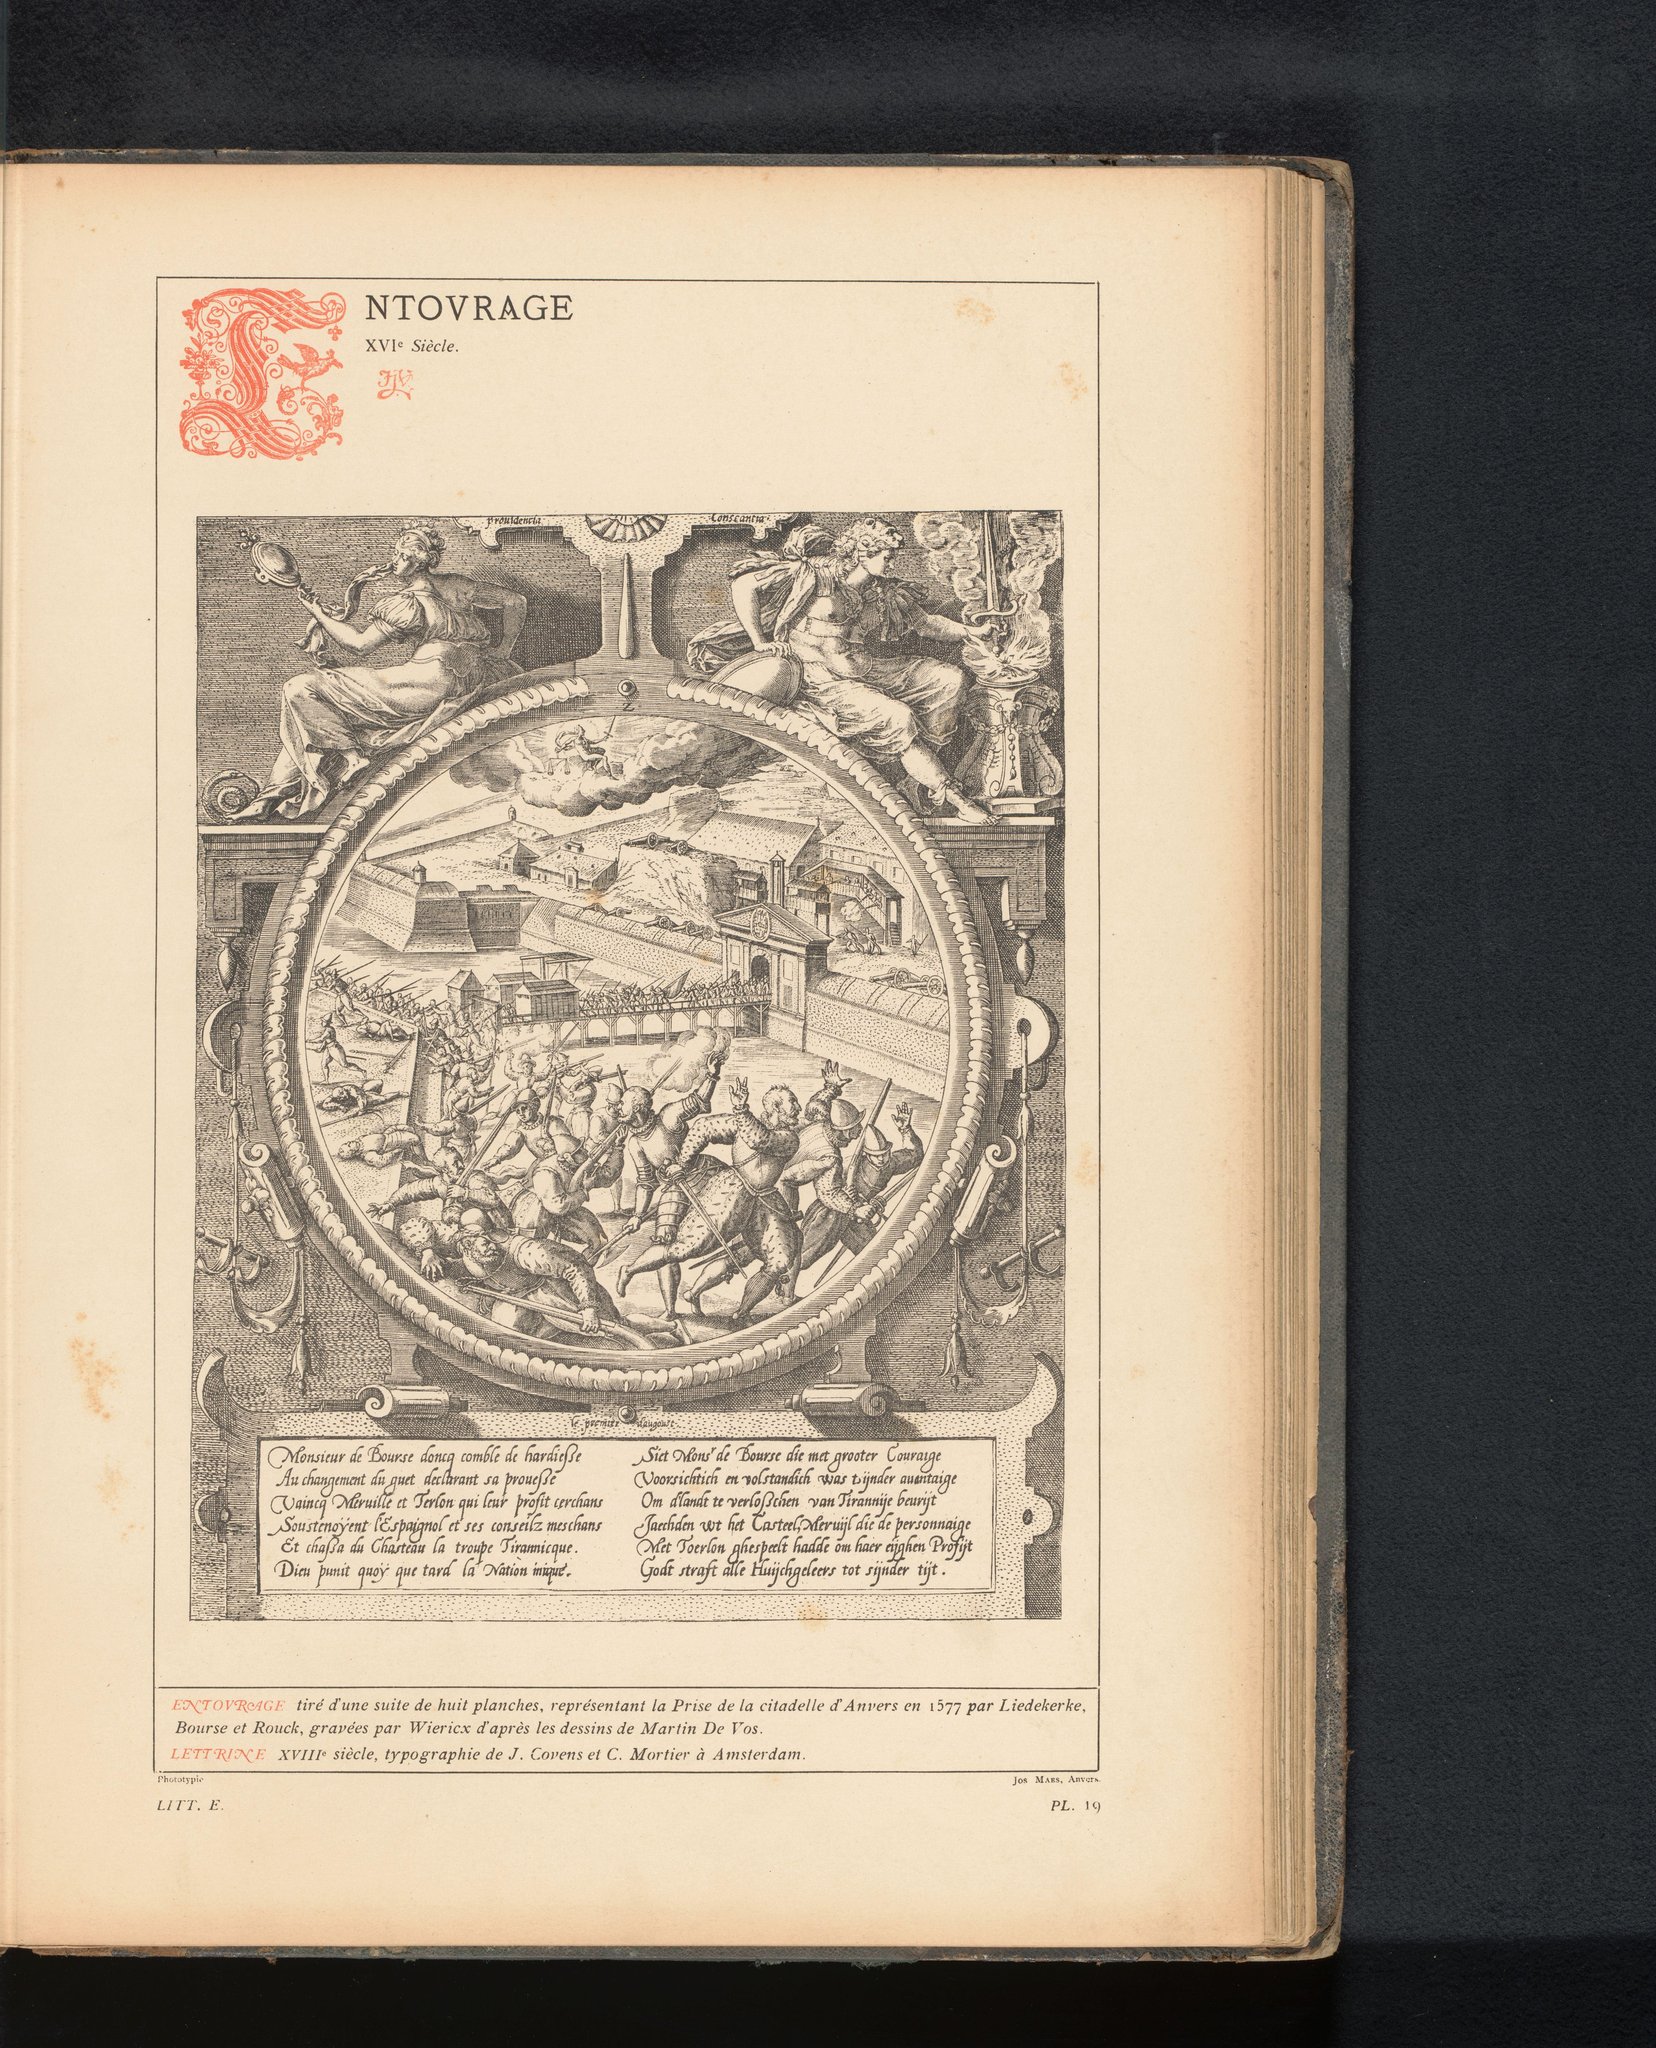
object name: reproduction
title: Reproductie van een prent van de inname van de citadel van Antwerpen in 1577 door Johannes Wierix naar Maerten de Vos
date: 1875-1880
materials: paper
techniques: photolithography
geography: amsterdam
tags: siege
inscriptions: monogram: ‘JJvY’, inscription: ‘ENTOURAGE tiré d'une (...)’, inscription: ‘LITT. E. - PL. 19’